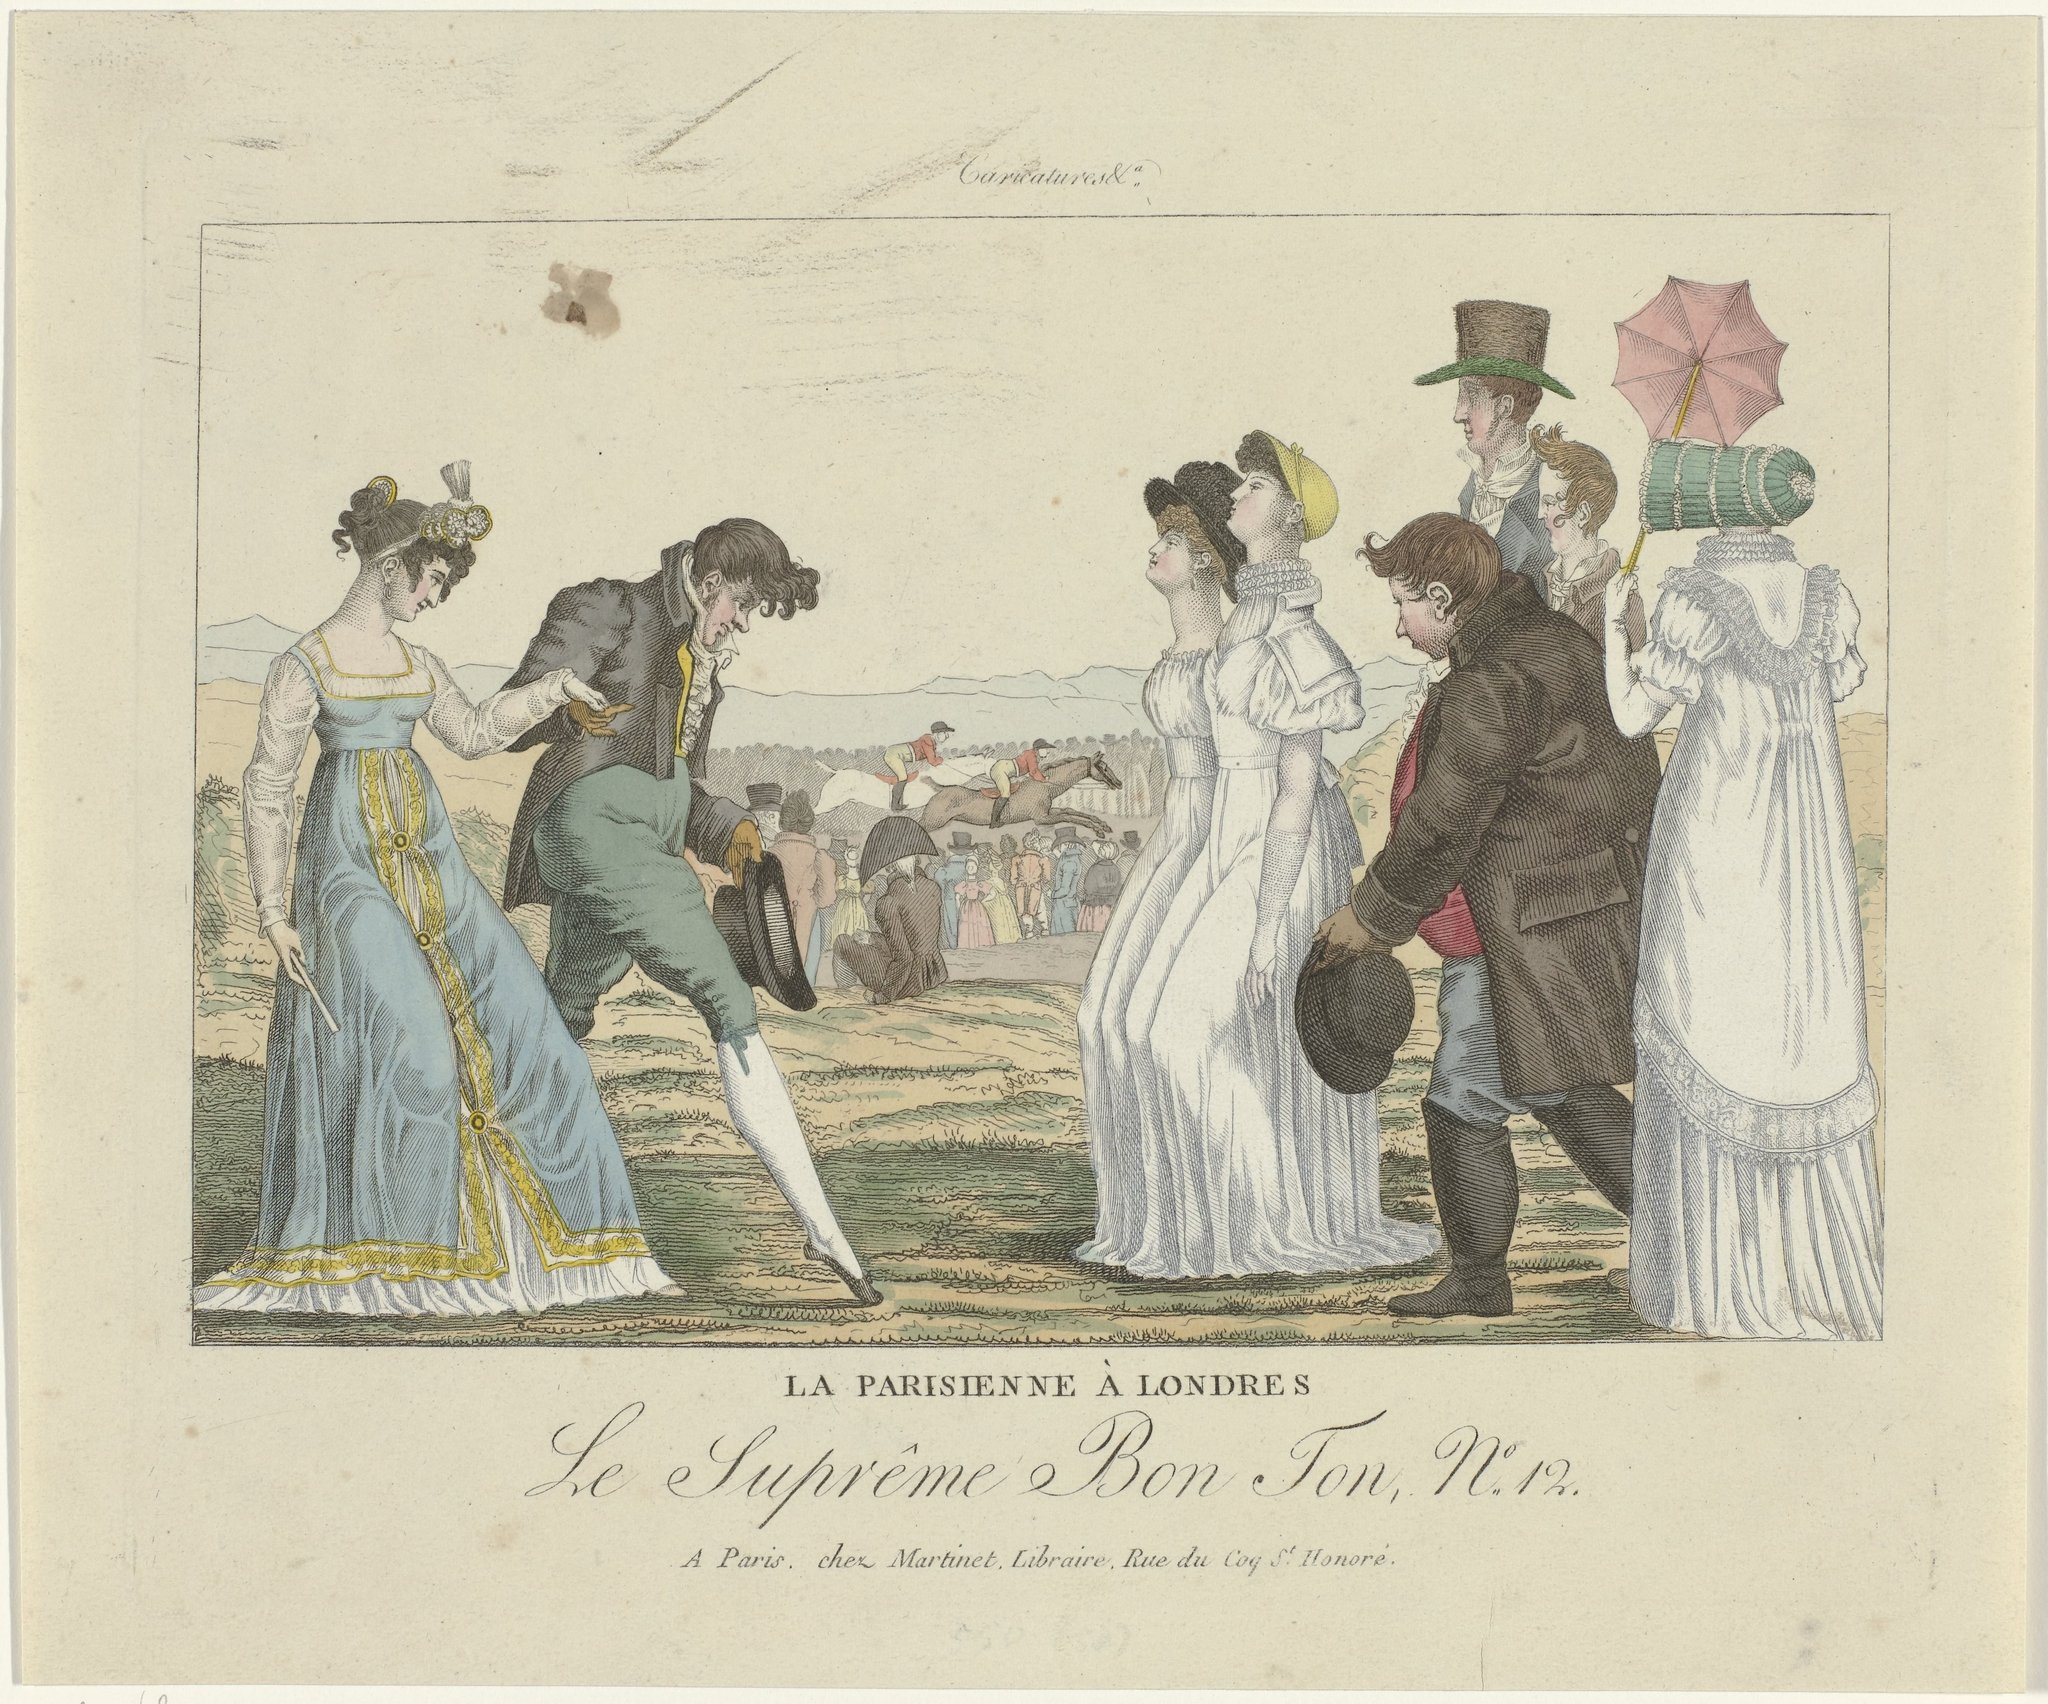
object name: fashion print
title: Le Suprême Bon Ton. Caricatures, 1800-1815, No 12: La Parisienne à Londres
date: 1800-1815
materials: paper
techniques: etching, hand coloring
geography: paris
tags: diadem, tiara (+ women's clothes), head-gear (poke bonnet) (+ women's clothes), coat (frac) (+ men's clothes), head-gear: hat (+ men's clothes), europeans: englishmen, fashion plates, clothes, costume (+ women's clothes), dress, gown (+ women's clothes), europeans (with name), head bent forward; bowing, clothes, costume (+ men's clothes), horse-racing, trousers, breeches, etc. (breeches) (+ men's clothes), gripping someone by the hand or the wrist; clasped hands, parasol, sunshade (+ women's clothes)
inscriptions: title: ‘Caricatures & "’, title: ‘Le Suprême Bon Ton, No. 12.’, caption: ‘LA PARISIENNE À LONDRES’, address: ‘A Paris, chez Martinet, Libraire, Rue du Coq S.t Honoré.’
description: Een modieus gekleed Frans paar buigt voor een groep Engelsen. Volgens het onderschrift zijn dit Parijzenaars in Londen. Op de achtergrond een renbaan met twee jockeys te paard. Prent uit een serie van 30 modeprenten, Le Suprême Bon Ton, Parijs, 1800-1815.